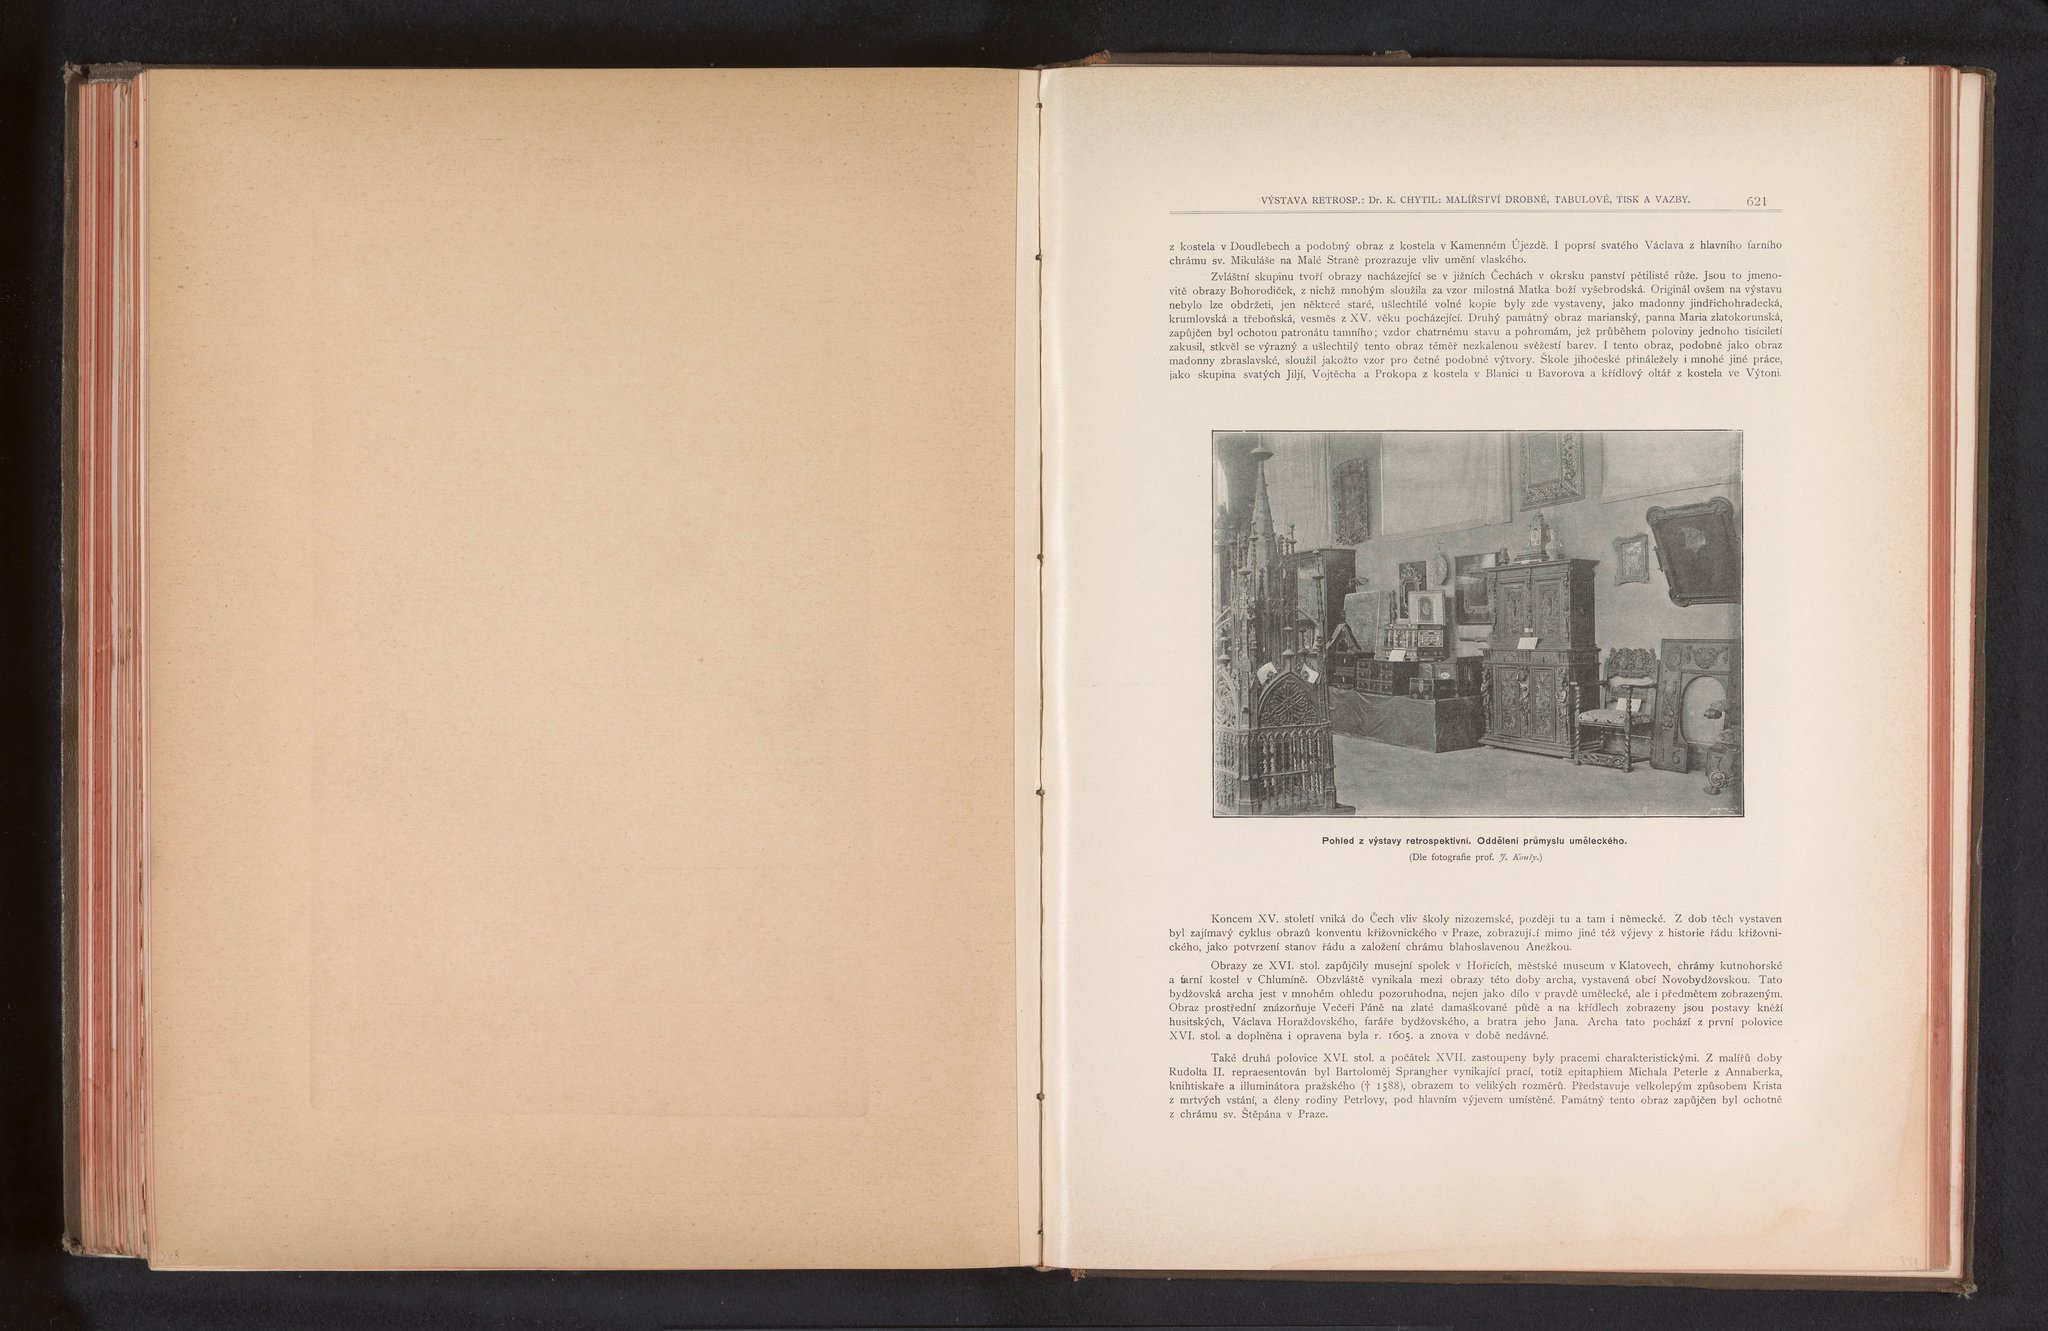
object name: photomechanical print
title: Tentoonstelling van houten meubels te Praag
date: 1891-1895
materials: paper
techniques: autotype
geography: prague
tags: furniture and household effects, collection, exhibition, show